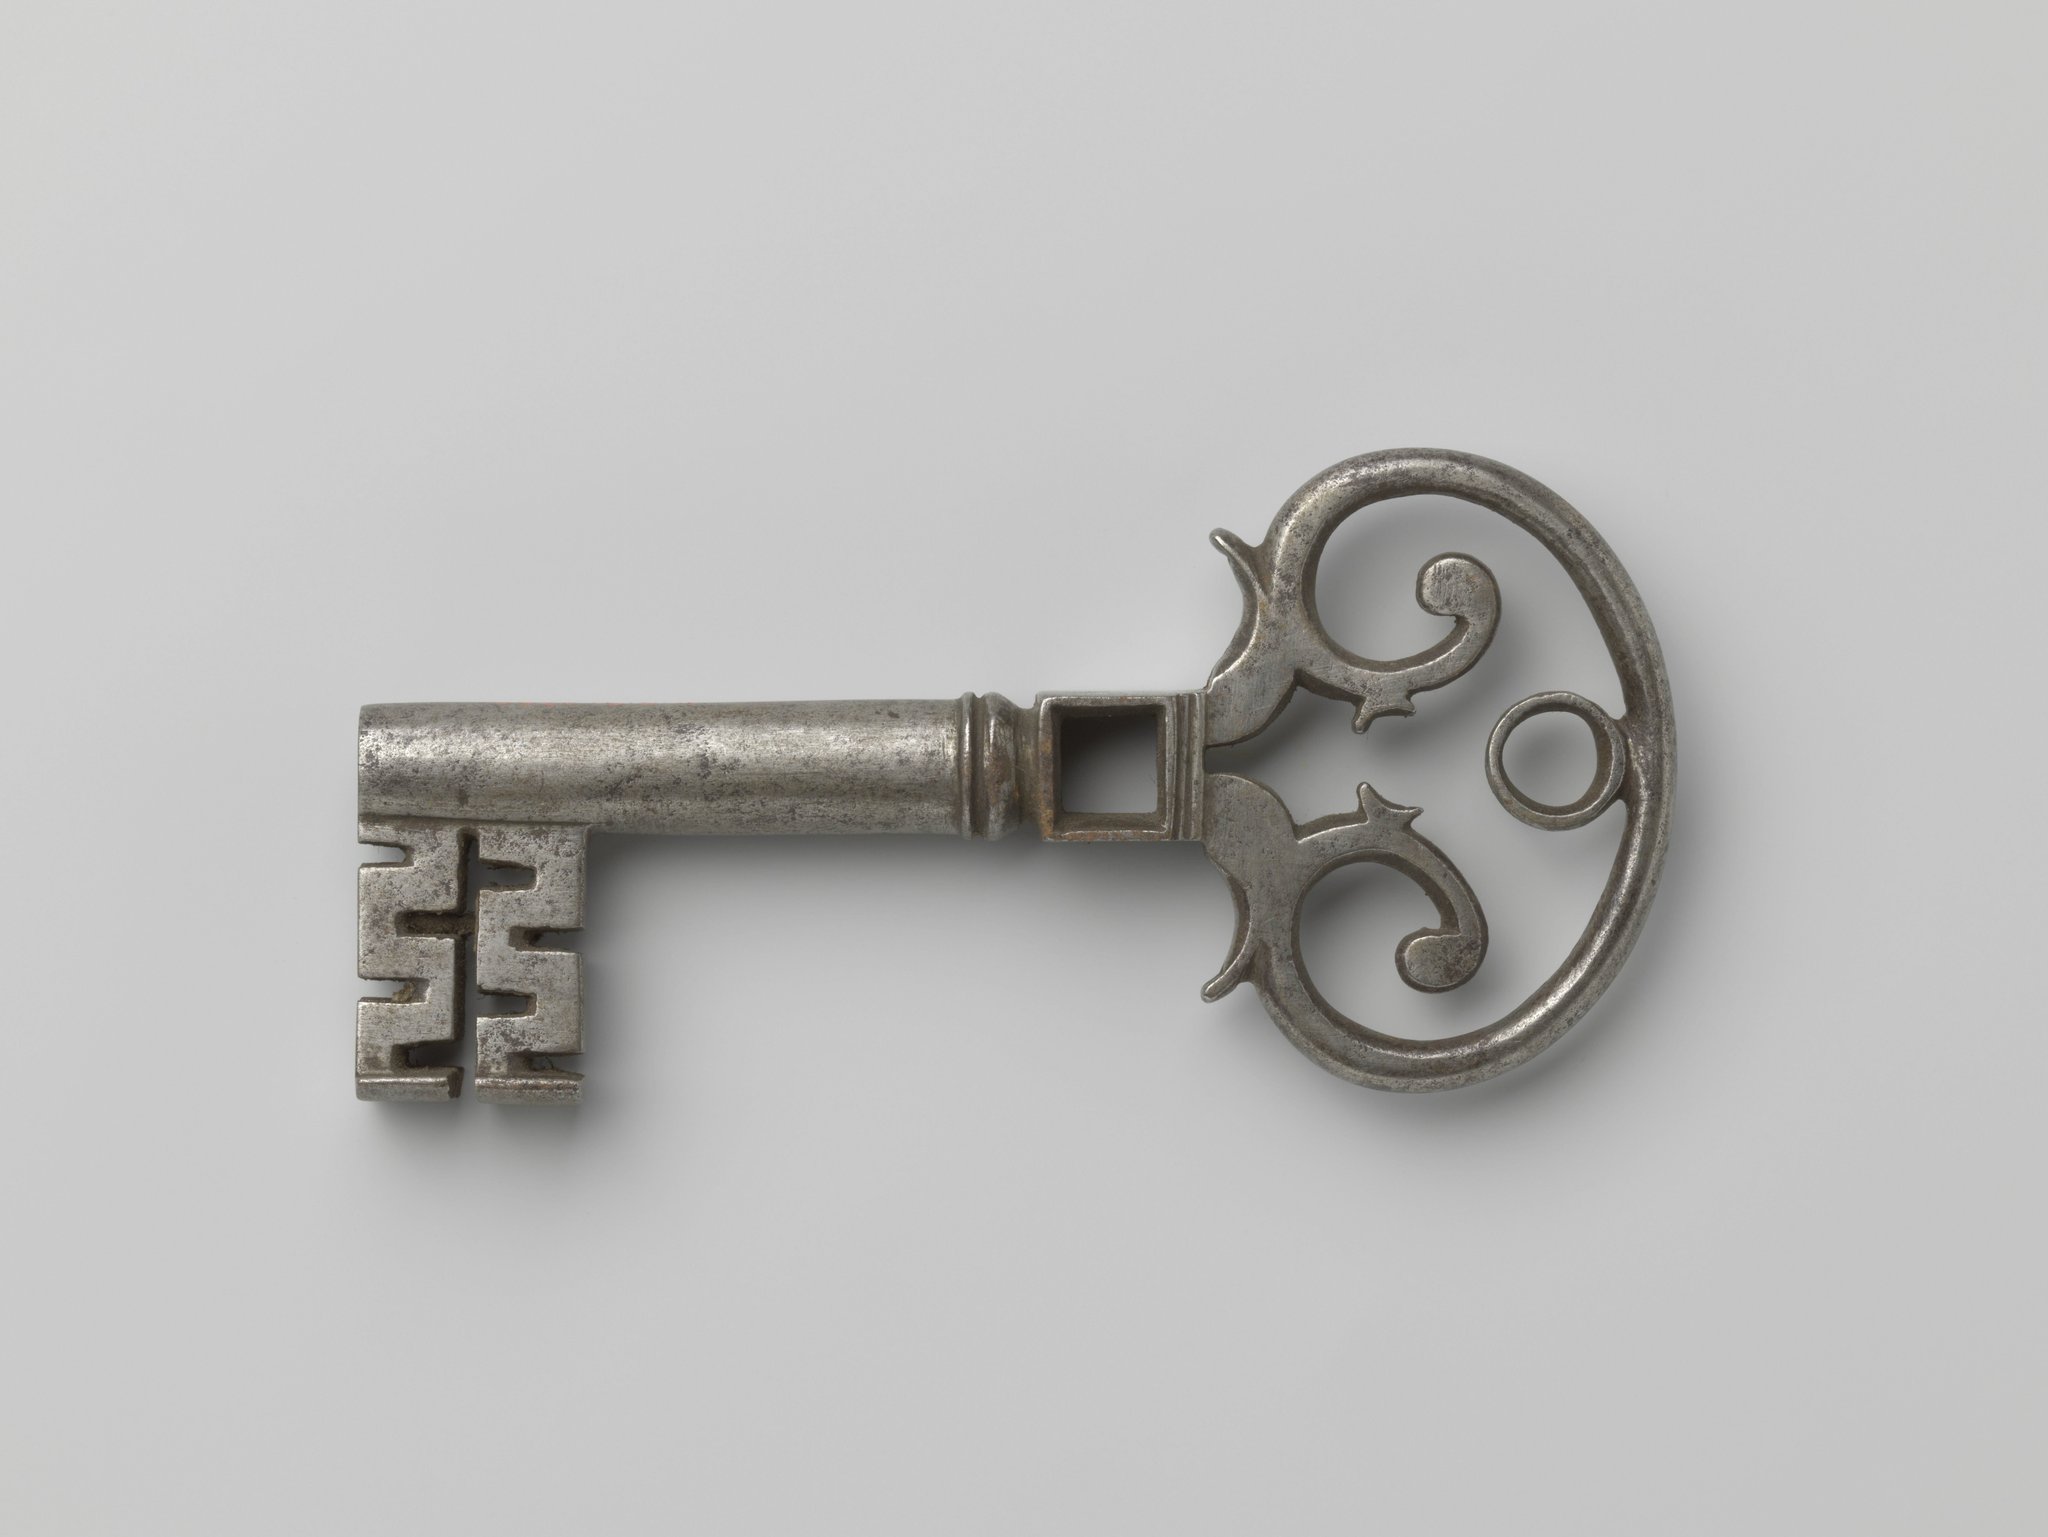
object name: pipe key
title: Pijpsleutel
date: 1700-1800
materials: iron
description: Pijpsleutel met vierkant open kapiteel en greep, bestaande uit een naar beneden gewende C-voluut, waarin aan de bovenzijde een oog hangt.